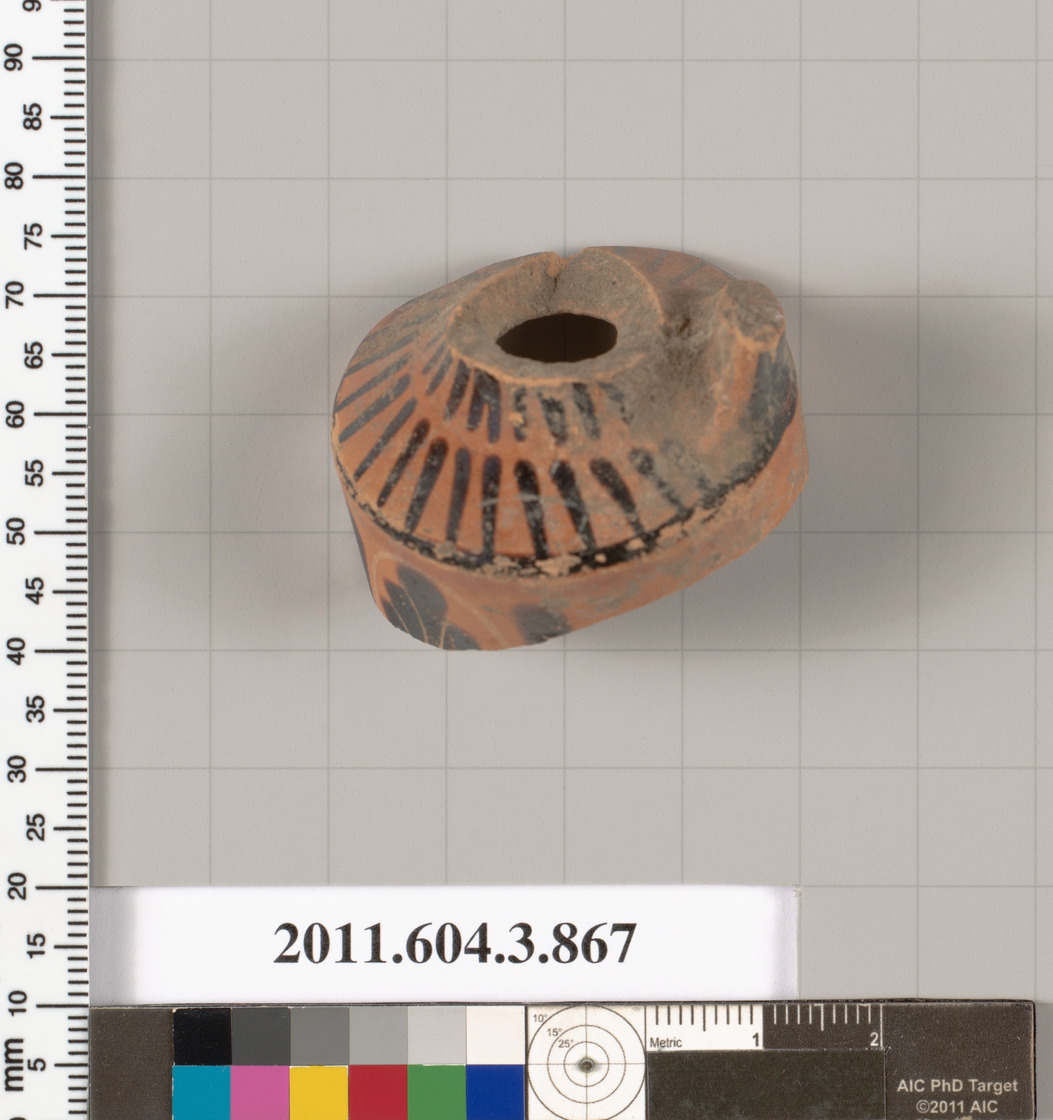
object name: lekythos fragment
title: Terracotta fragment of a lekythos (oil flask)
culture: greek, attic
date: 534-501 BCE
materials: terracotta